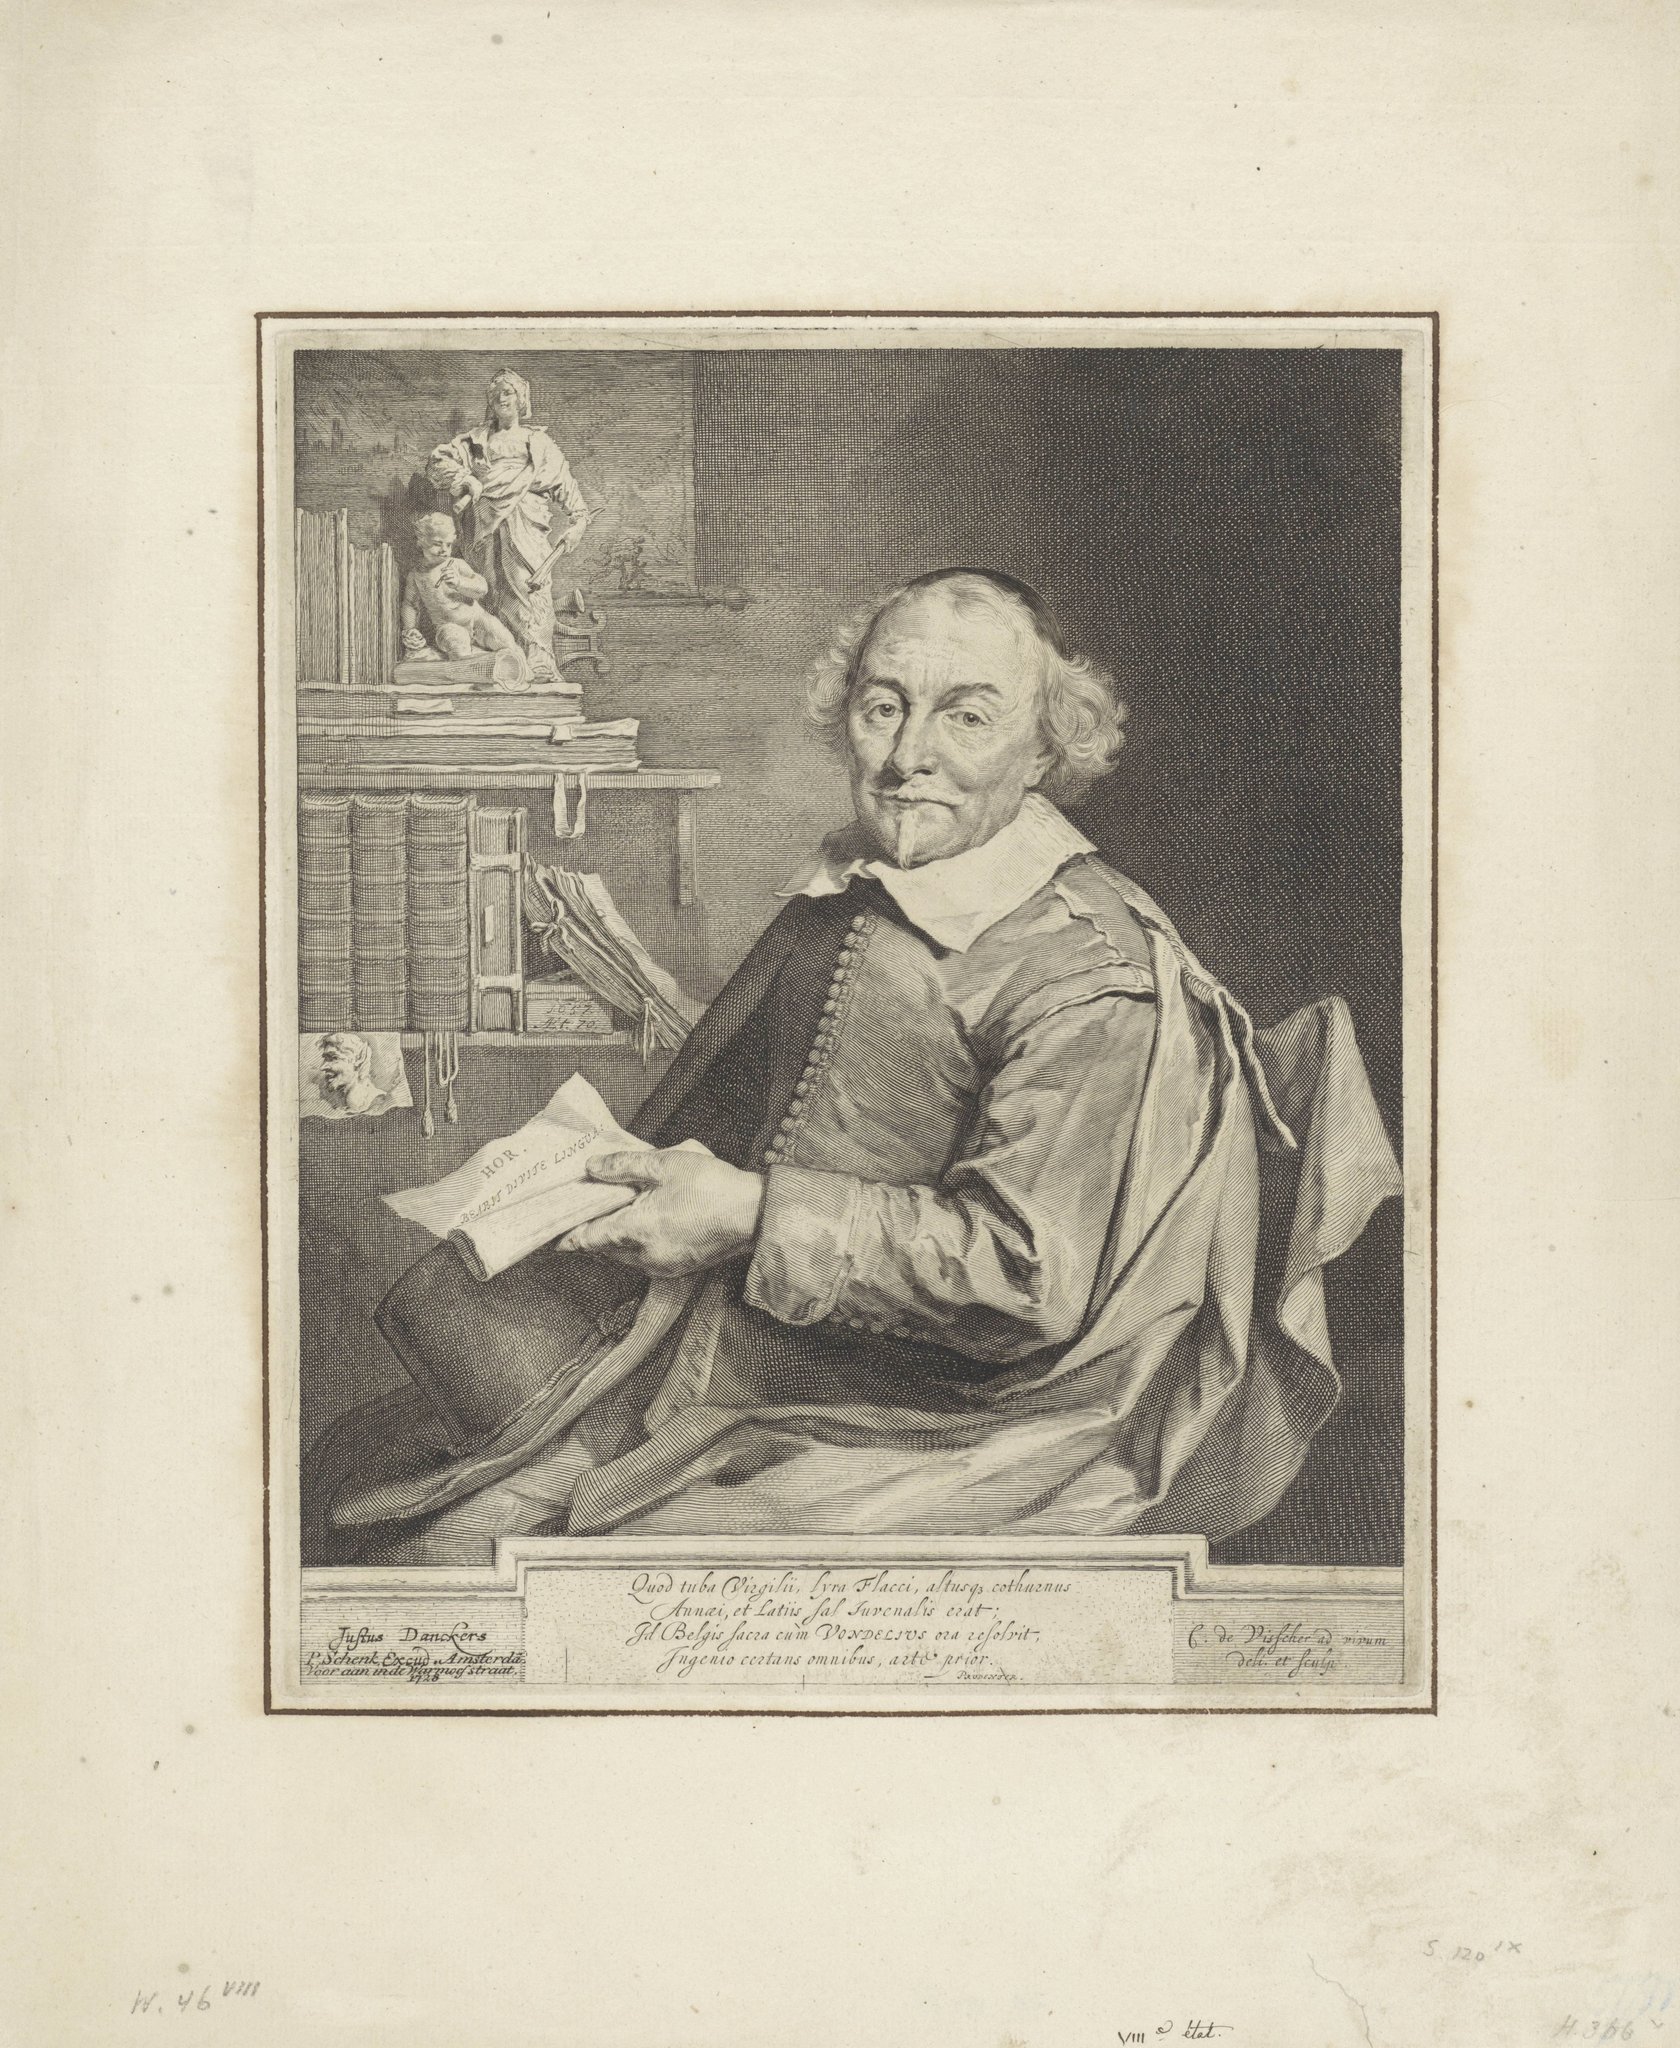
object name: print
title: Portret van Joost van den Vondel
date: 1728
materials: paper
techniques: engraving, etching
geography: amsterdam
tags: amsterdam, joost van den vondel, print, e.g.: engraving, etching, lithograph, head-gear: hat (+ men's clothes), sculpture, cupids: 'amores', 'amoretti', 'putti'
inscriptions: collector's mark: Lugt 2228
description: De schrijver en dichter Joost van den Vondel op 70-jarige leeftijd in zijn werkkamer. Hij draagt een kalot en heeft een beschreven rol papier in zijn hand. Hij zit bij twee planken met boeken en beelden van een vrouw en een putto. Aan de muur hangt een op stokken geslagen prent.